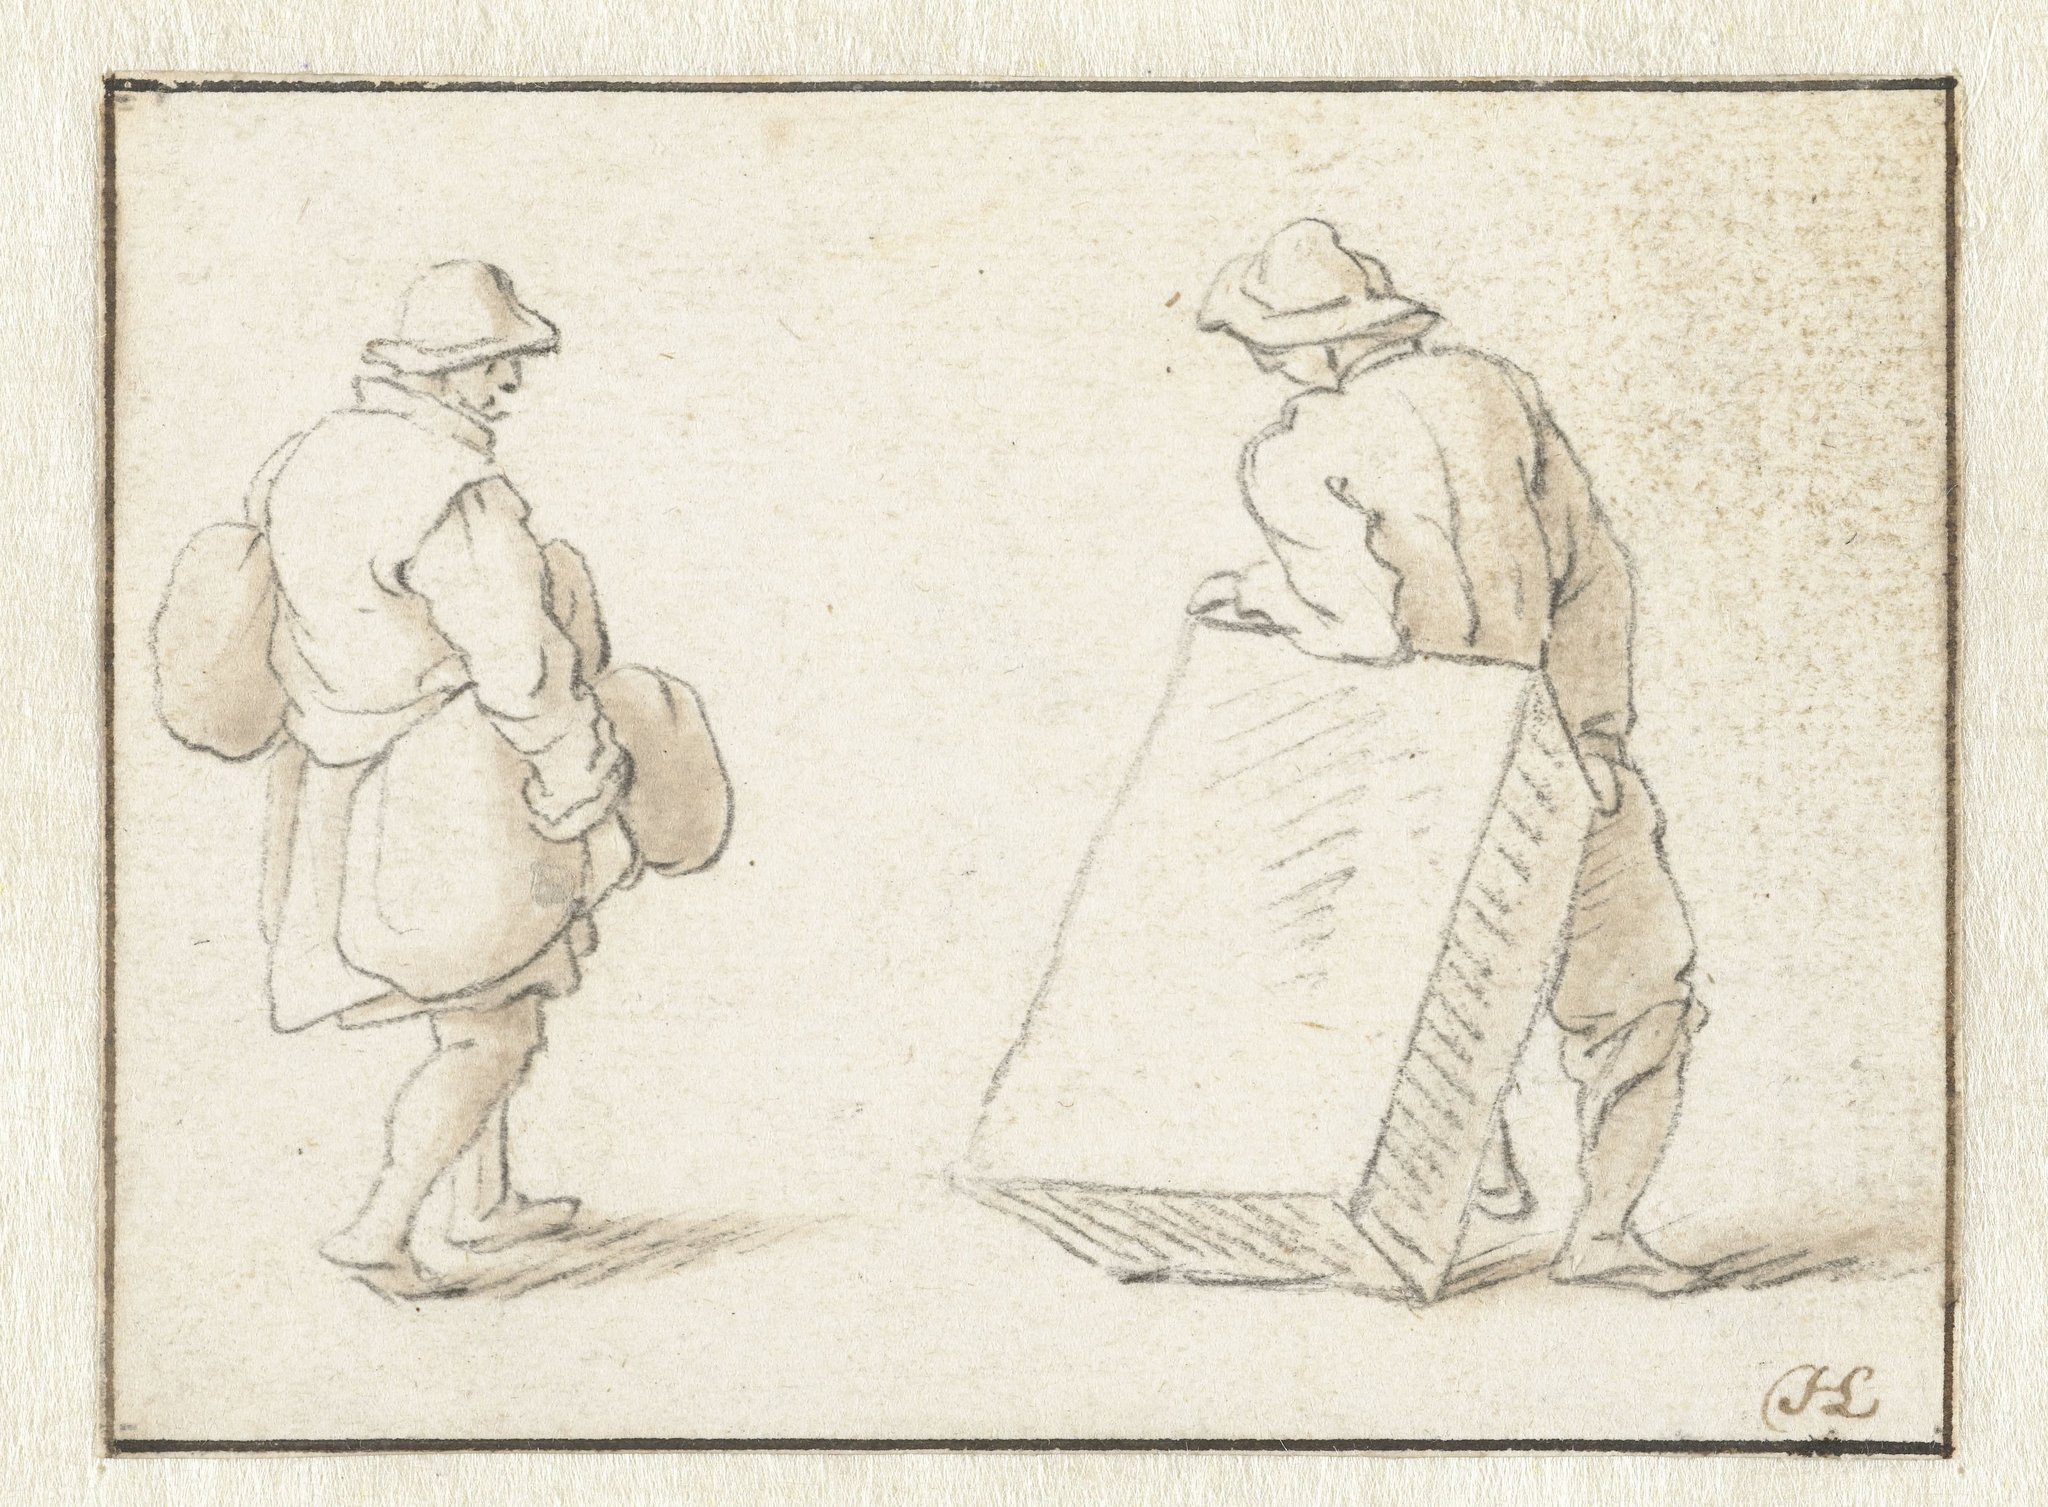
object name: drawing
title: Man met twee zakken en een man met een grote kist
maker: herman saftleven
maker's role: draughtsman, painter, print maker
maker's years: 1609-1685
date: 1619-1685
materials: chalk, paper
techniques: brush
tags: carrying something, walking